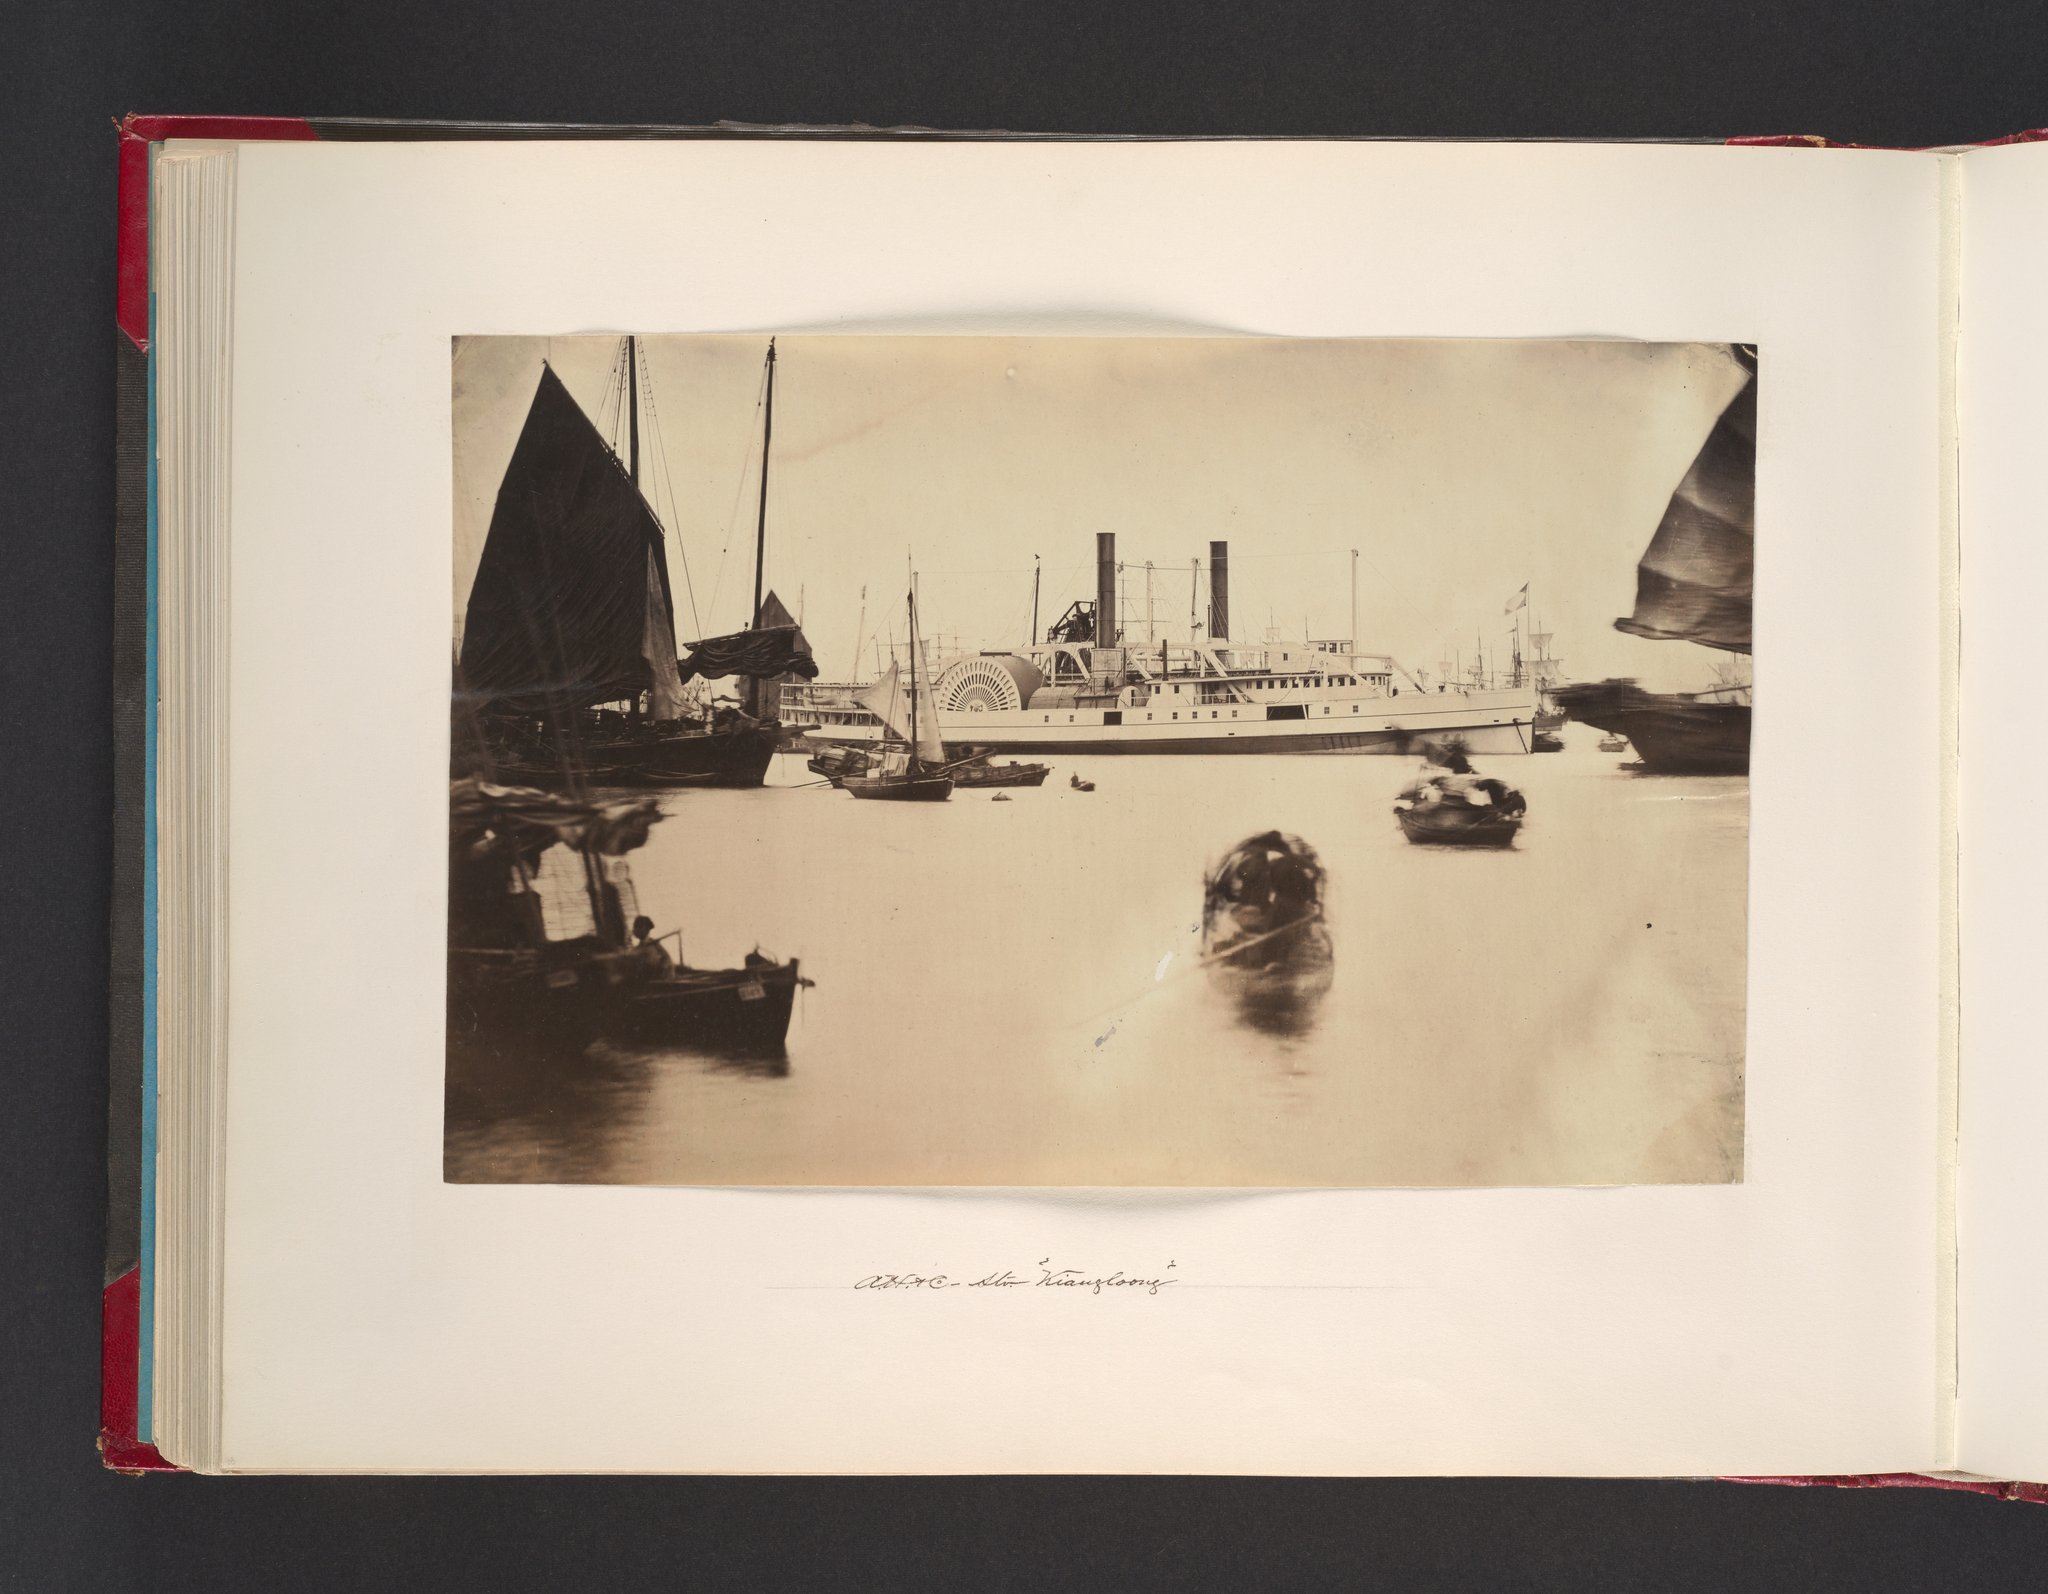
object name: photograph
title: Augustine Heard & Co. Steamer "Kiangloong"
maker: john thomson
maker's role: artist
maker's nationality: british, scottish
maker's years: 1837-1921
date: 1865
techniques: albumen silver print, glass negative